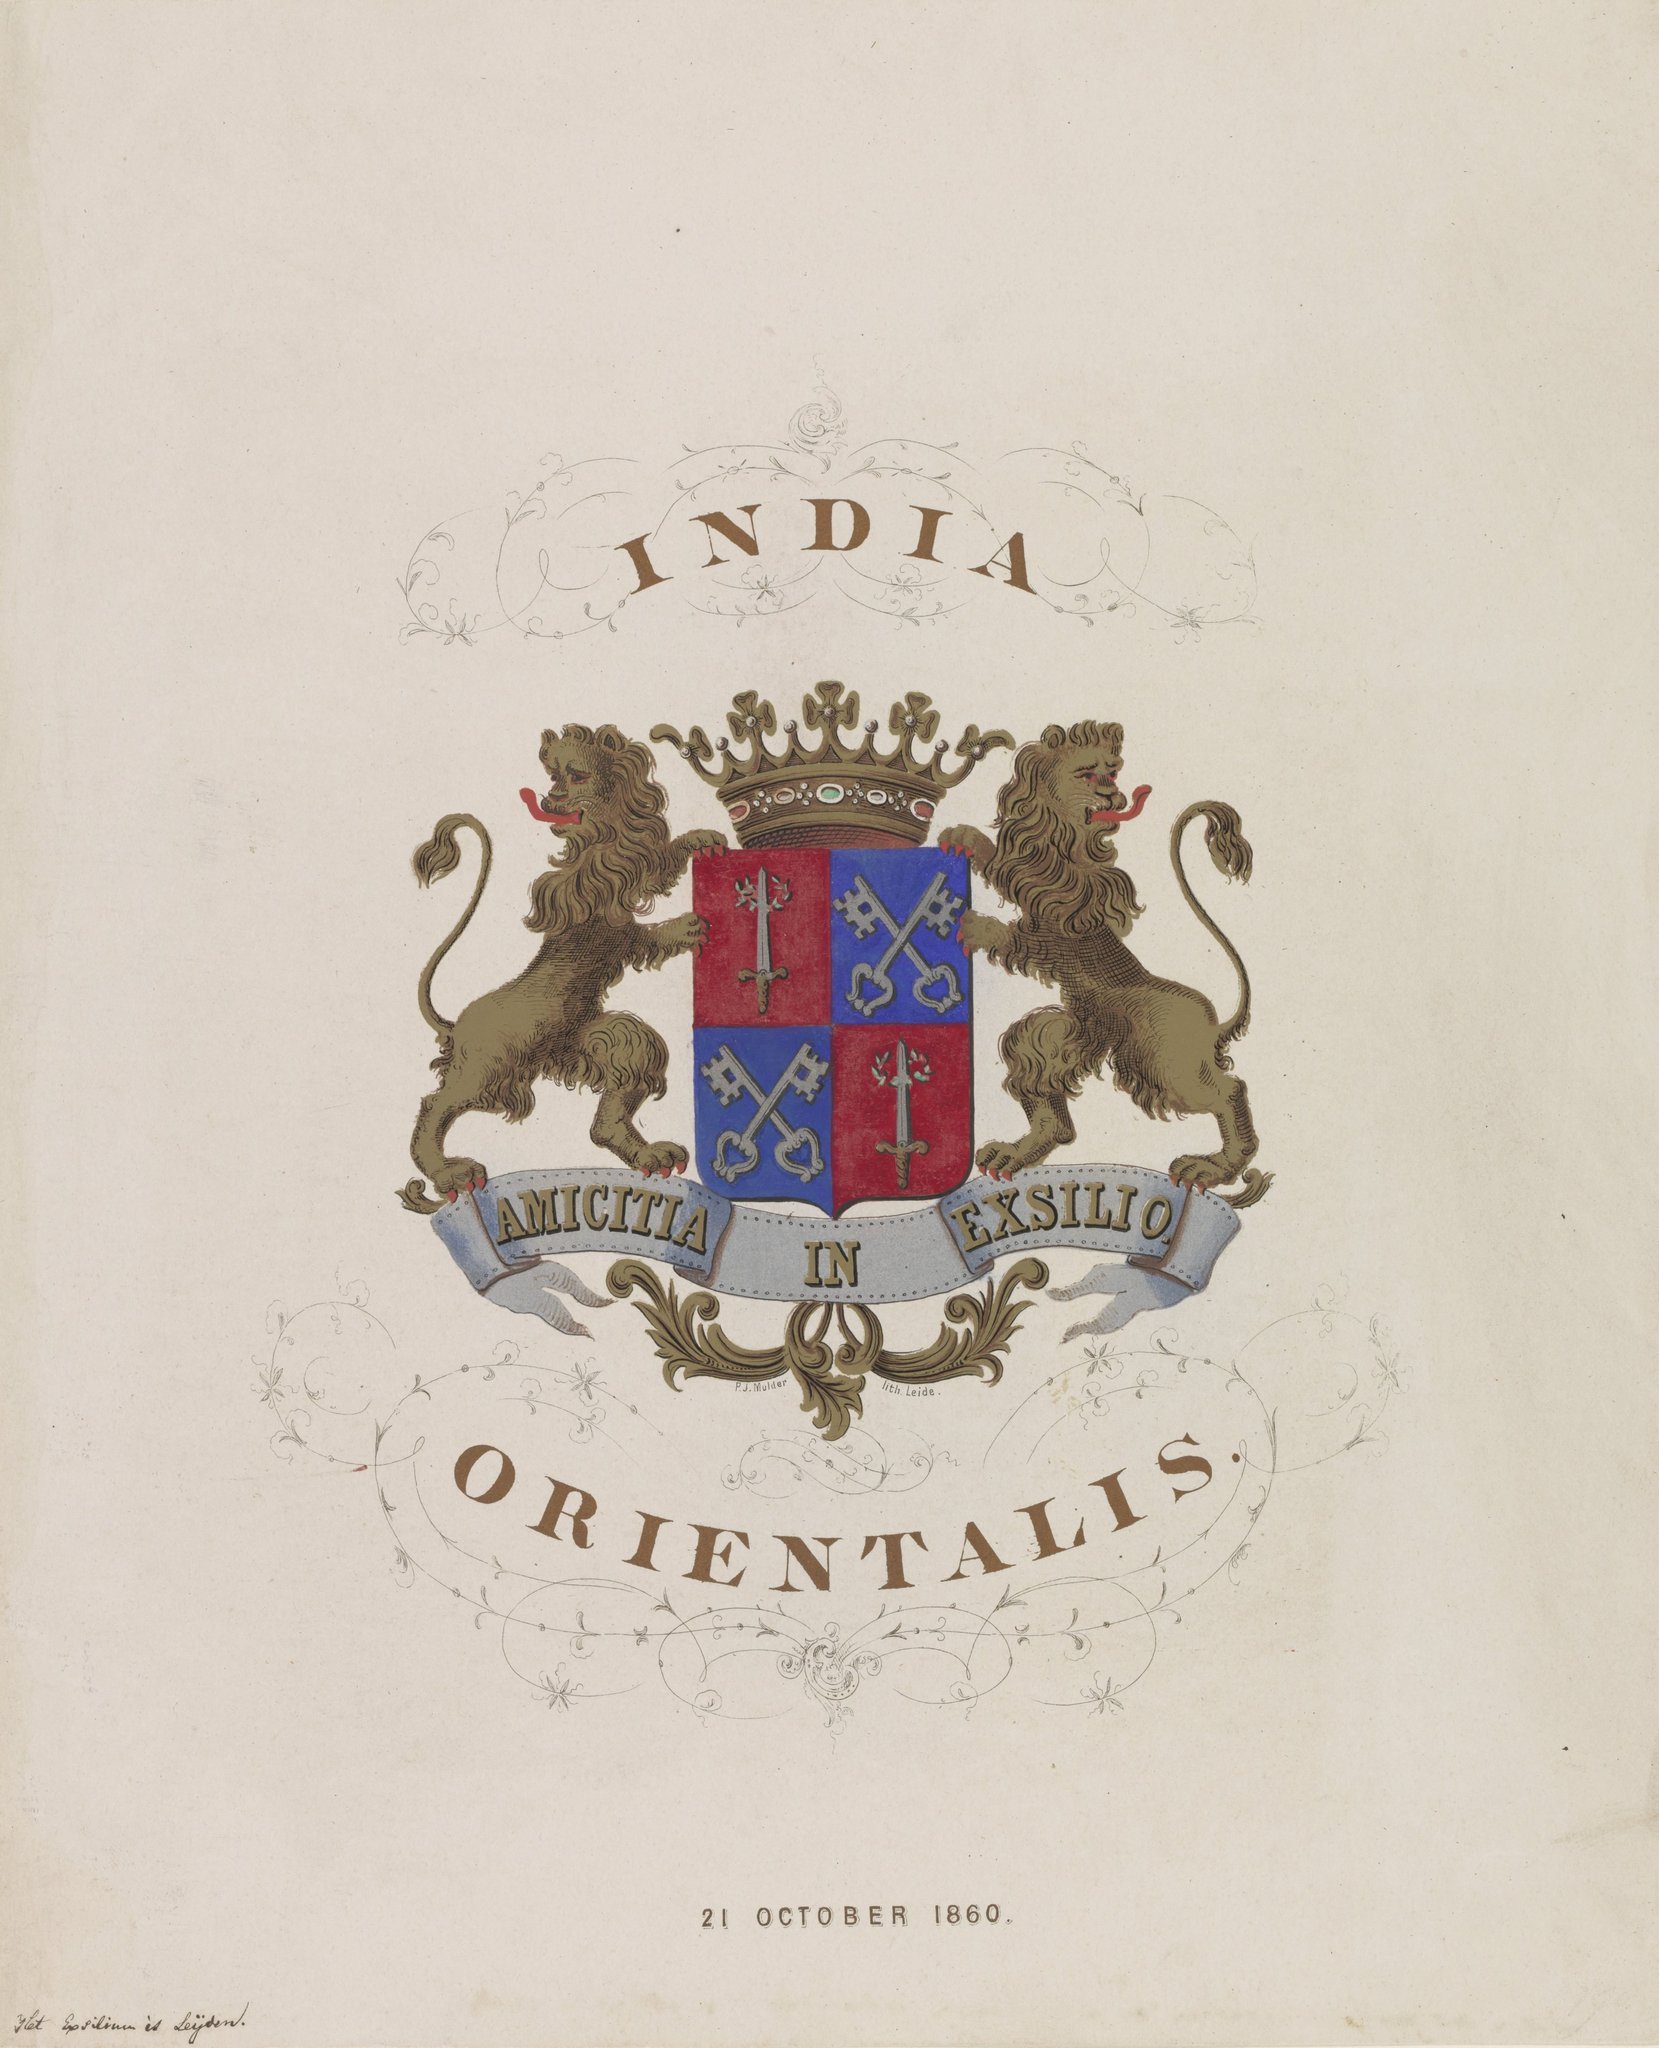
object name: print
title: Wapen van het genootschap India Orientalis, 1860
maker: pieter jacobus mulder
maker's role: draughtsman, print maker, printer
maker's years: 1836-1923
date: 1860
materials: paper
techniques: chromolithography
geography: leiden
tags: fraternity (students), armorial bearing, heraldry, leiden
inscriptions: collector's mark: Lugt 2228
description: Het wapen van het streekgezelschap 'India Orientalis', opgericht door studenten uit de voormalige kolonie Nederlands-Indië aan de Universiteit van Leiden, 21 oktober 1860. Onderdeel van de Leidse Studenten Vereniging 'Minerva'.